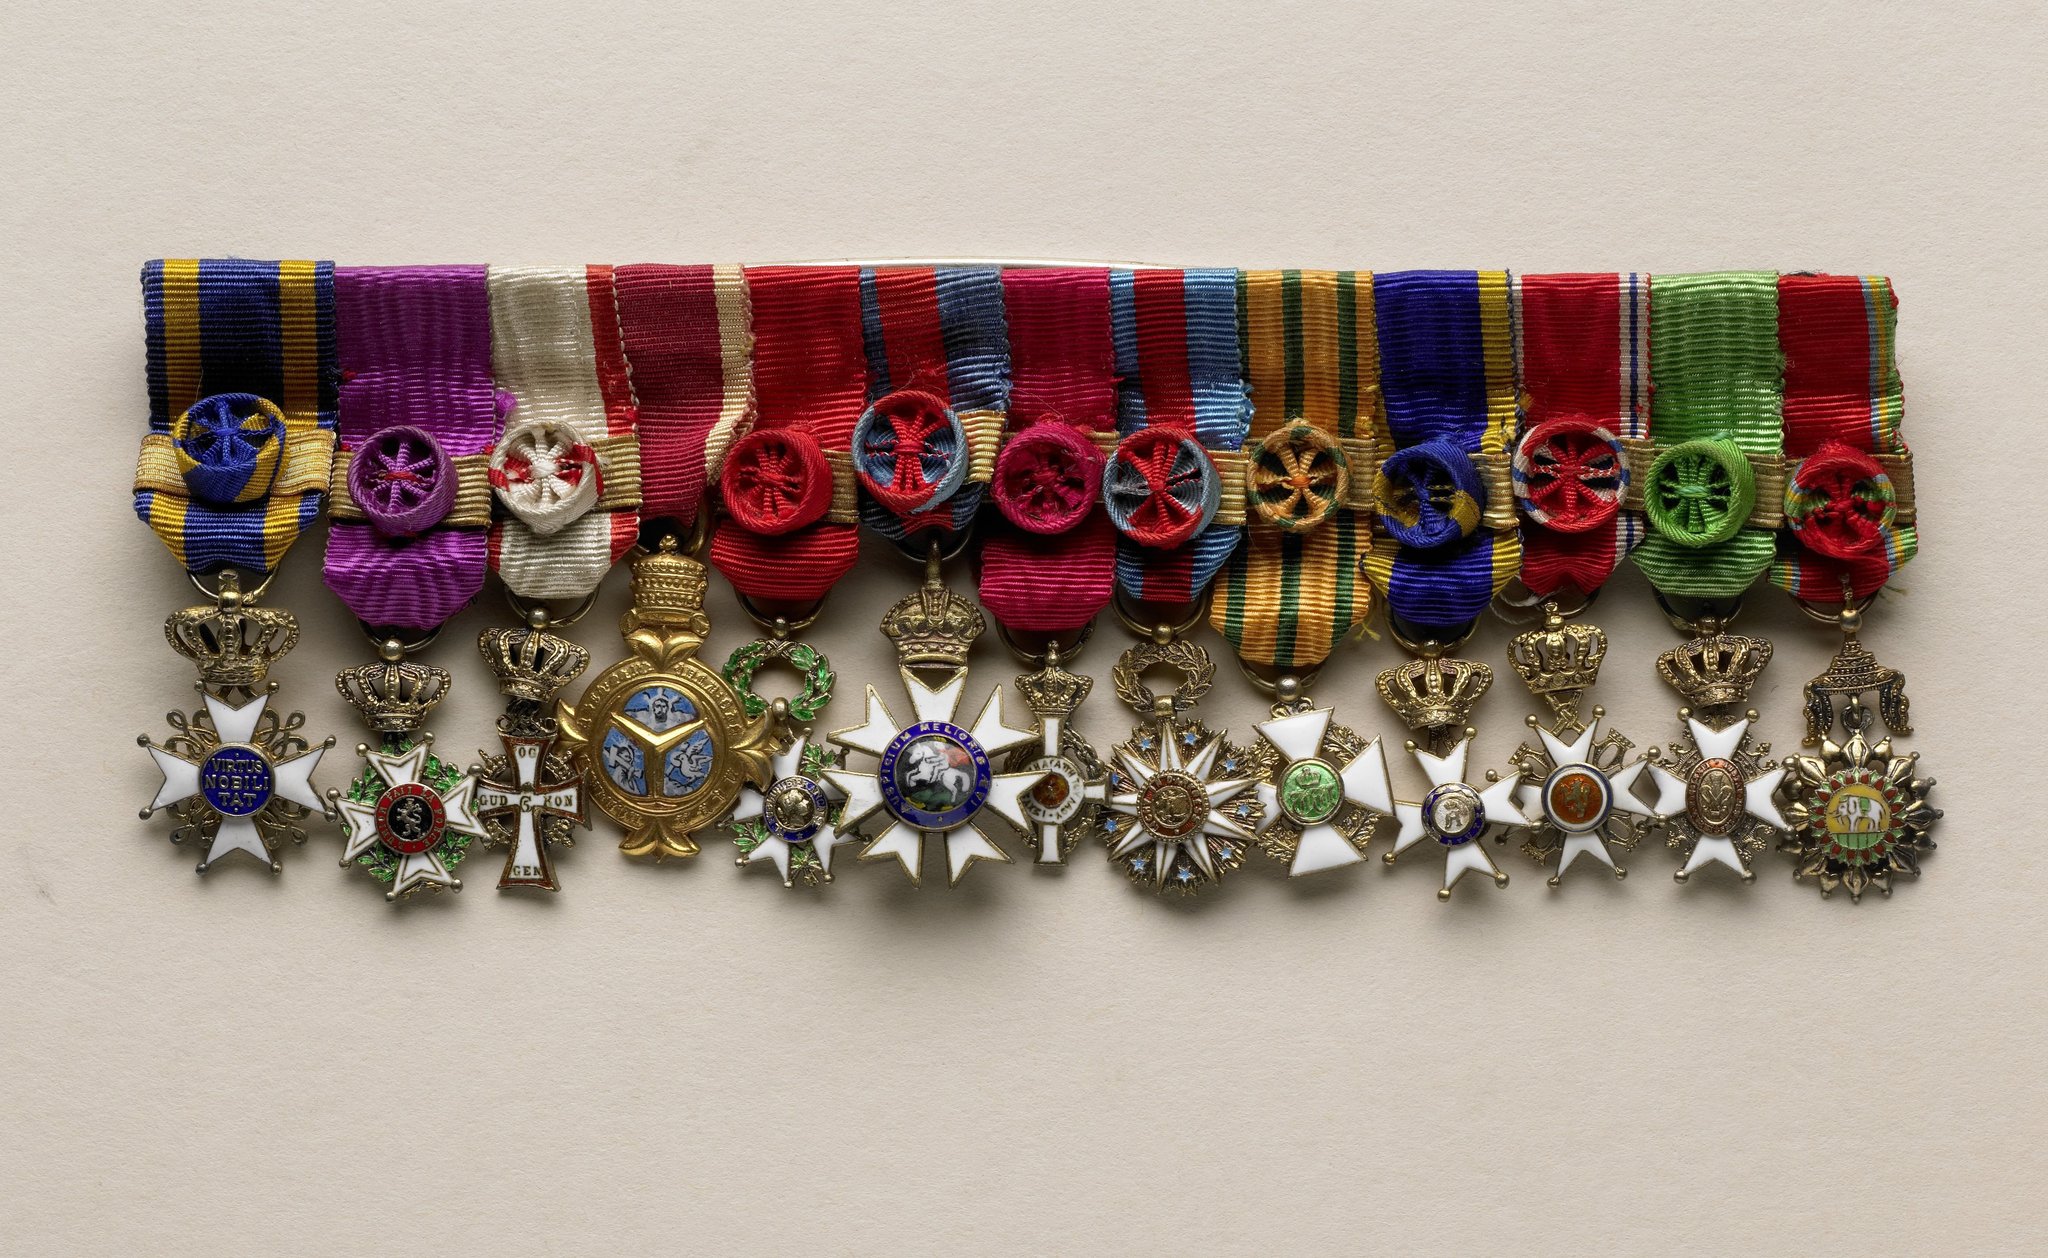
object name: ordeteken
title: Miniatuur ordetekens van Willem Drees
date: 1950-1988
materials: metal, textile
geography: the hague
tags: amsterdam, the hague, willem drees, netherlands, france, thailand, norway, belgium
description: Speld met dertien miniatuur ordetekens (behorend bij de grootkruizen) van Willem Drees om op kostuum te dragen. De volgorde van links naar rechts is: Nederlandse leeuw LIB 1 = Grand Cross of the Order of Leopold of Belgium DD 1 = Grand Cross of Order of Dannebrog, of Denmark HDE 1 = Grand Cross of the Order of the Holy Trinity of Ethiopia LEF 1 = Grand Cross of the Order of the Légion d'Honneur of France Orde van Sint Michaël en Sint George van Groot Brittannië CIG 1 = Crand Cross of the Order of George I of Greece SAL 1 = Grand Cross of the Order of the Star of Africa of Liberia EKL 1 = Grand Cross of Order of Crown of Oak of Luxemburg ANL 1 = Grand Cross Order of Adolf van Nassau of Luxemburg SON 1 = Grand Cross of the Order of St. Olav of Norway VZ 1 = Grand Cross of the Order of Vasa of Sweden WOTh 1 = Grand Cross of the Order of the White Elephant of Thailand De letters zijn de officiële afkortingen van deze decoraties.